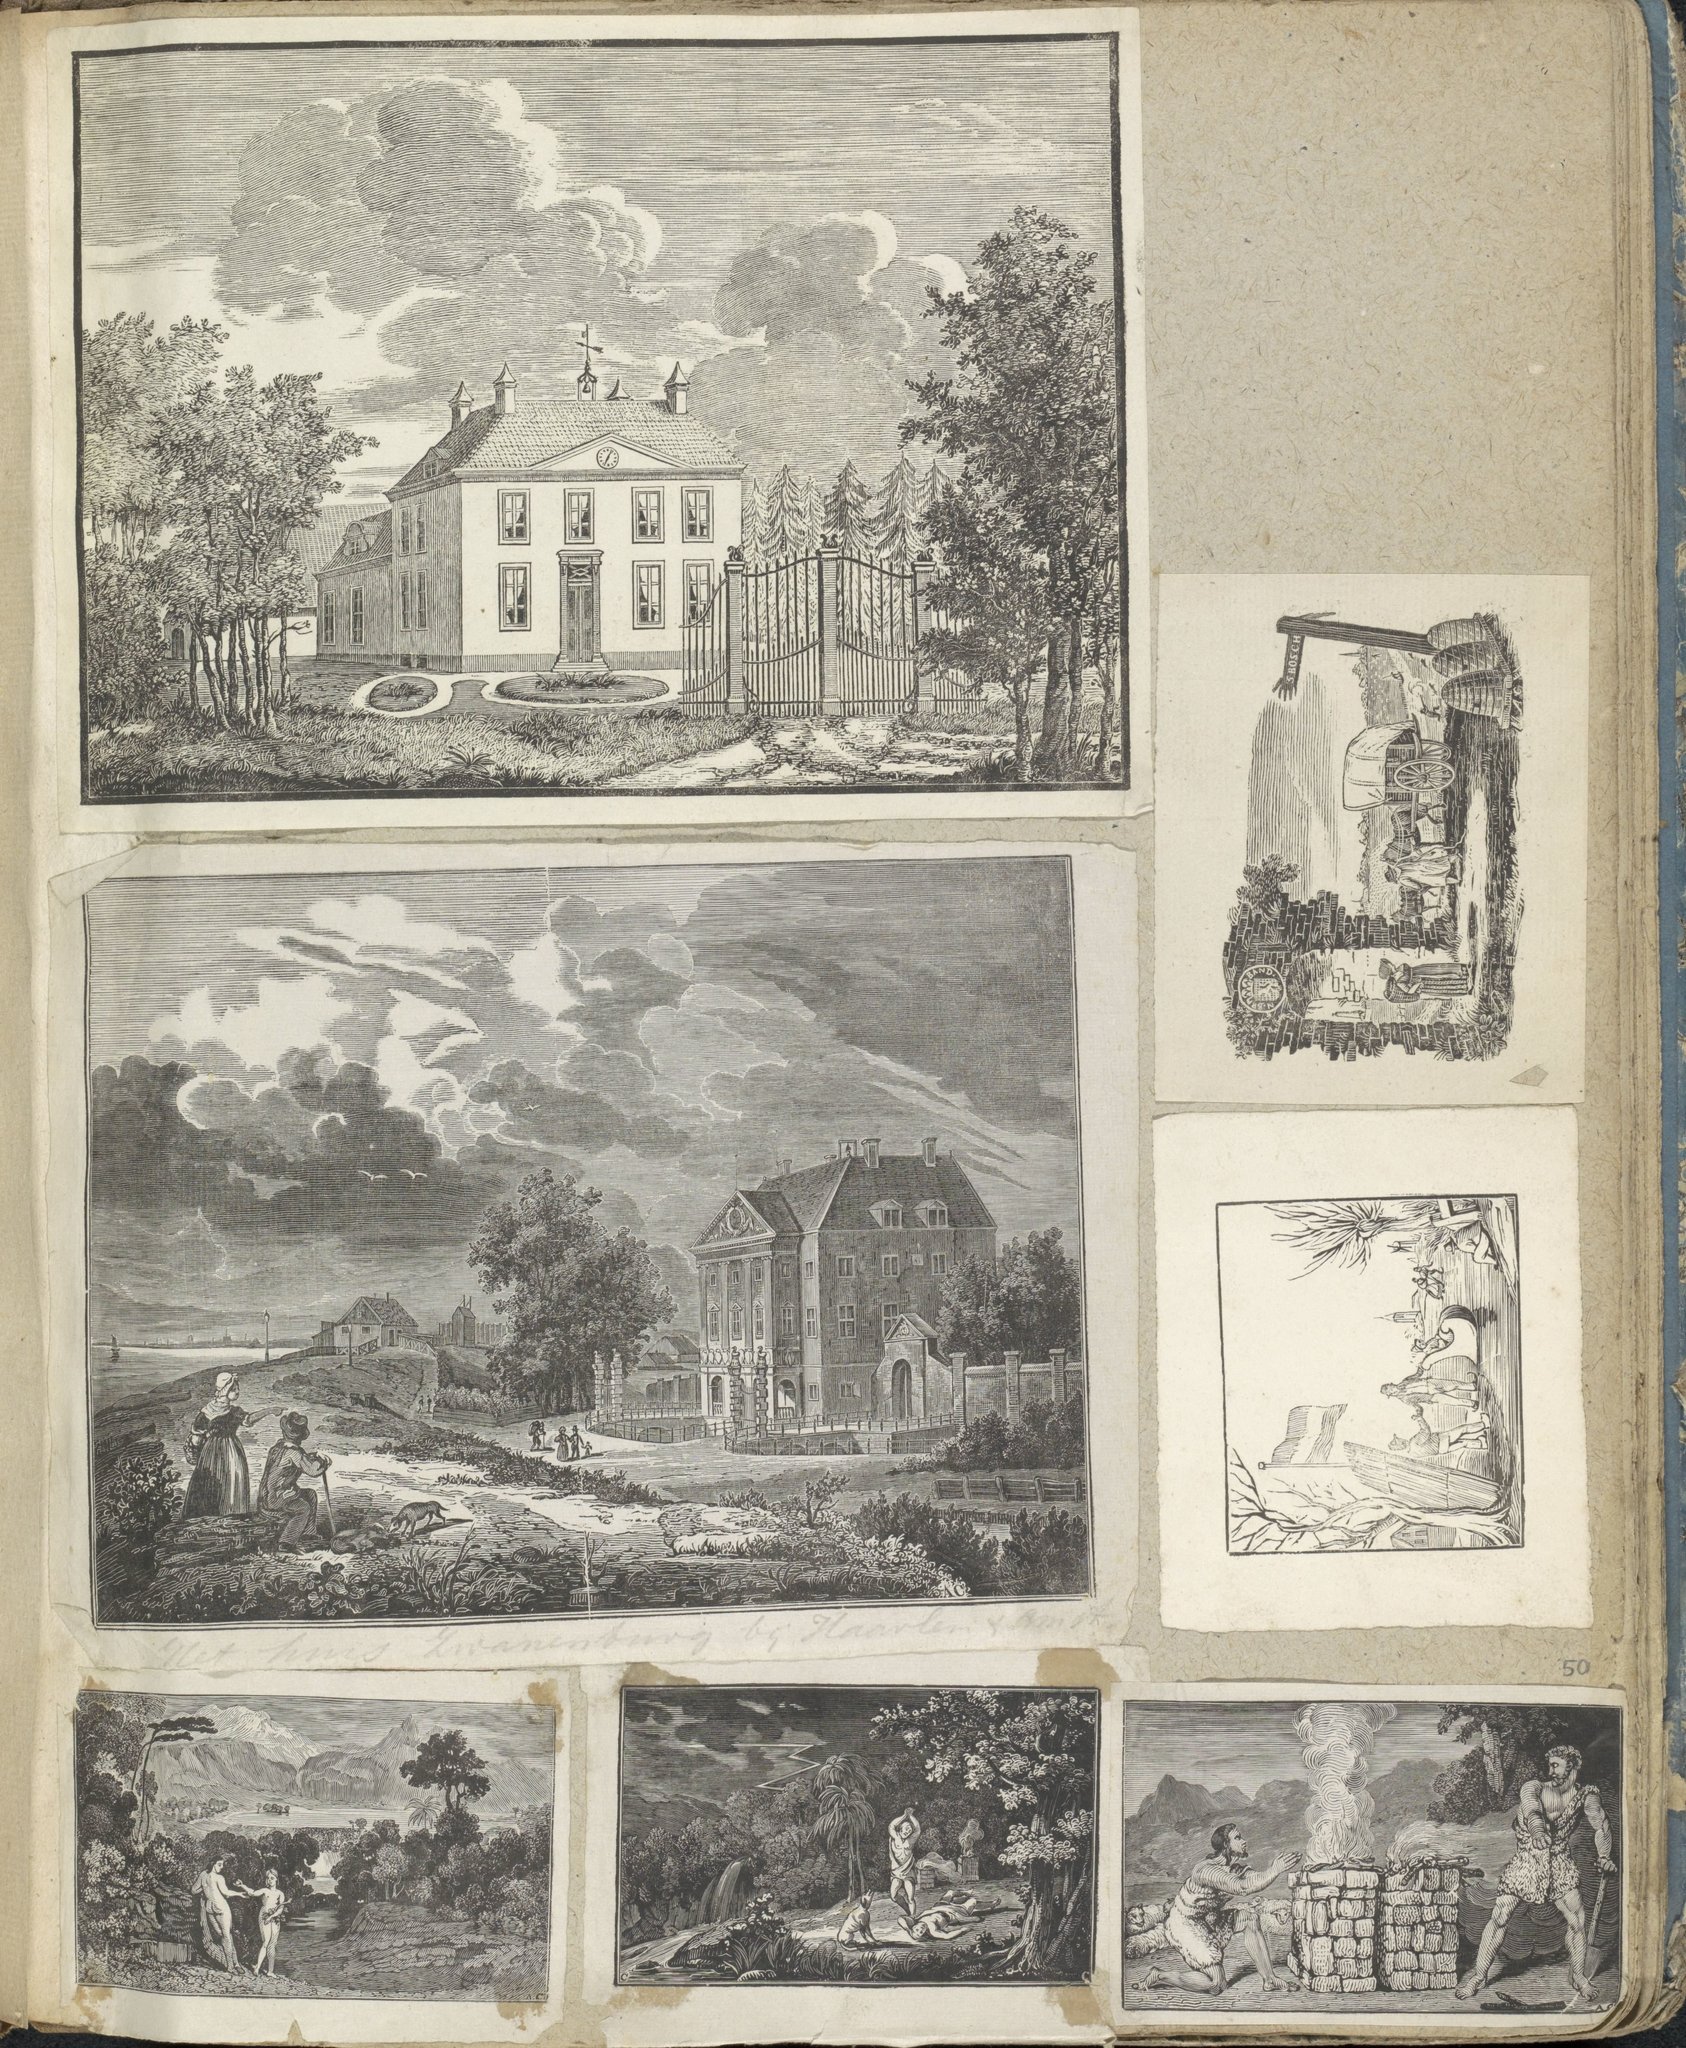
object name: print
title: Albumblad met diverse voorstellingen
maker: alexander cranendoncq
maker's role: draughtsman, print maker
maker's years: 1799-1869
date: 1814-1869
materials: paper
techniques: snipping, engraving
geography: nijmegen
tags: city-view, and landscape with man-made constructions, abel's death, landscapes, adam and eve in paradise (before the fall), sleigh, sledge (non-sport), skates (winter sports), den bosch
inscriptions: inscription: ‘Het huis Zwanenburg bij Haarlem [...]’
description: Albumblad met 7 uitgeknipte voorstellingen uit voornamelijk volksprenten, van onder andere Huis Zwanenburg te Halfweg, Adam en Eva in het paradijs en de dood van Abel.